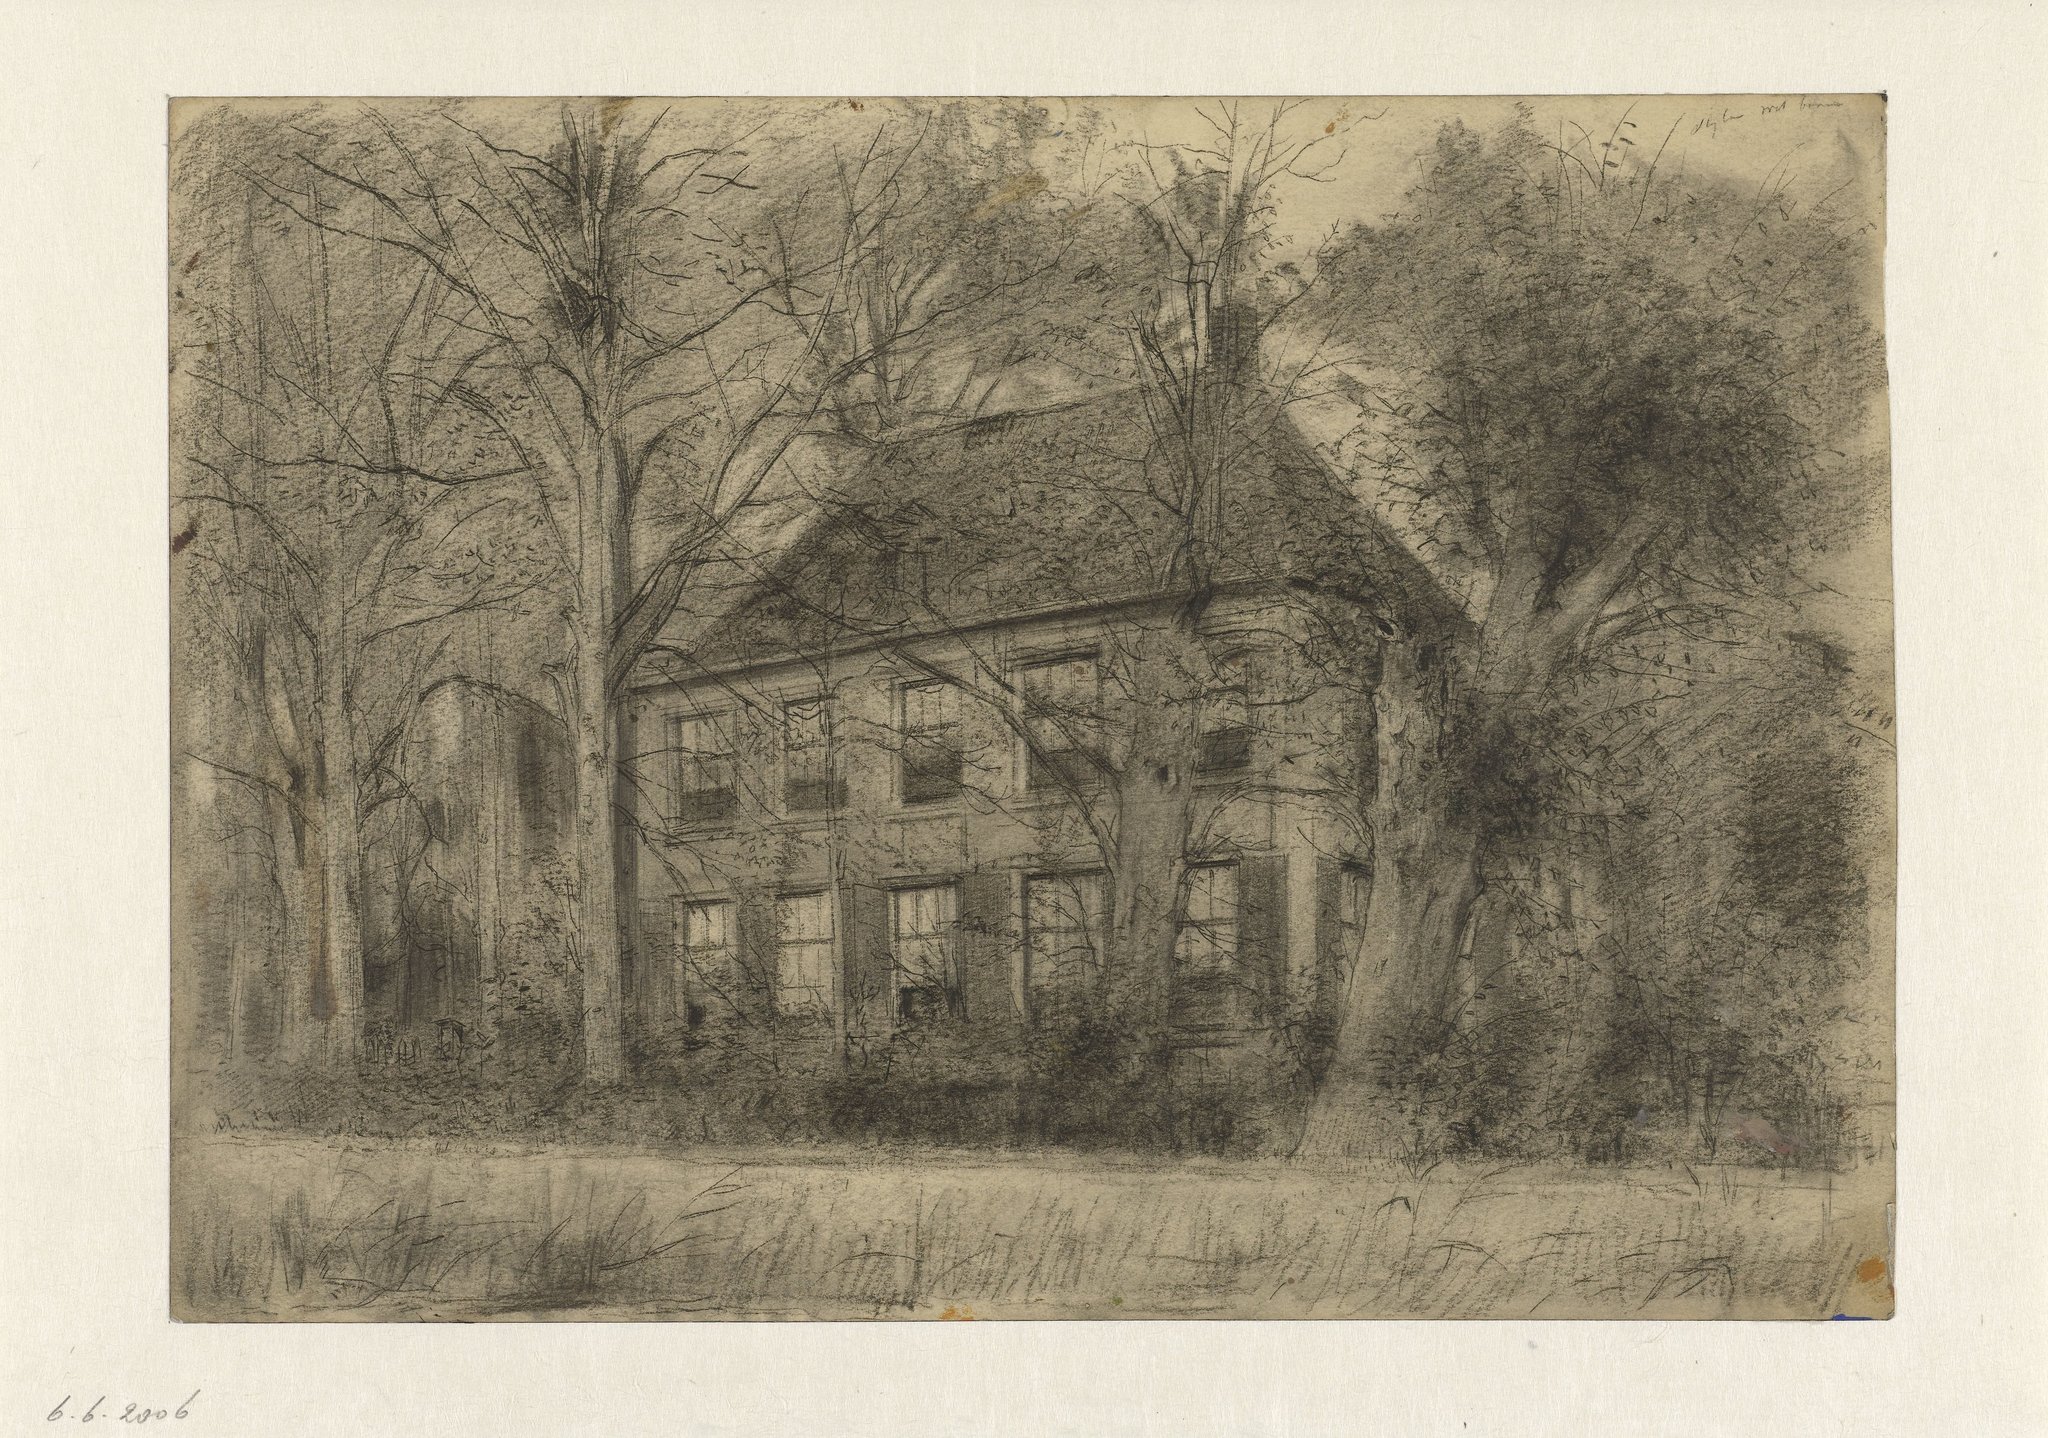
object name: drawing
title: Oude woning aan het Gein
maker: cornelis gerardus t hooft (1791-1871)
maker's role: draughtsman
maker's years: 1791-1871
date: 1801-1871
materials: chalk, paper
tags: rural housing, e.g. country-house, villa, cottage